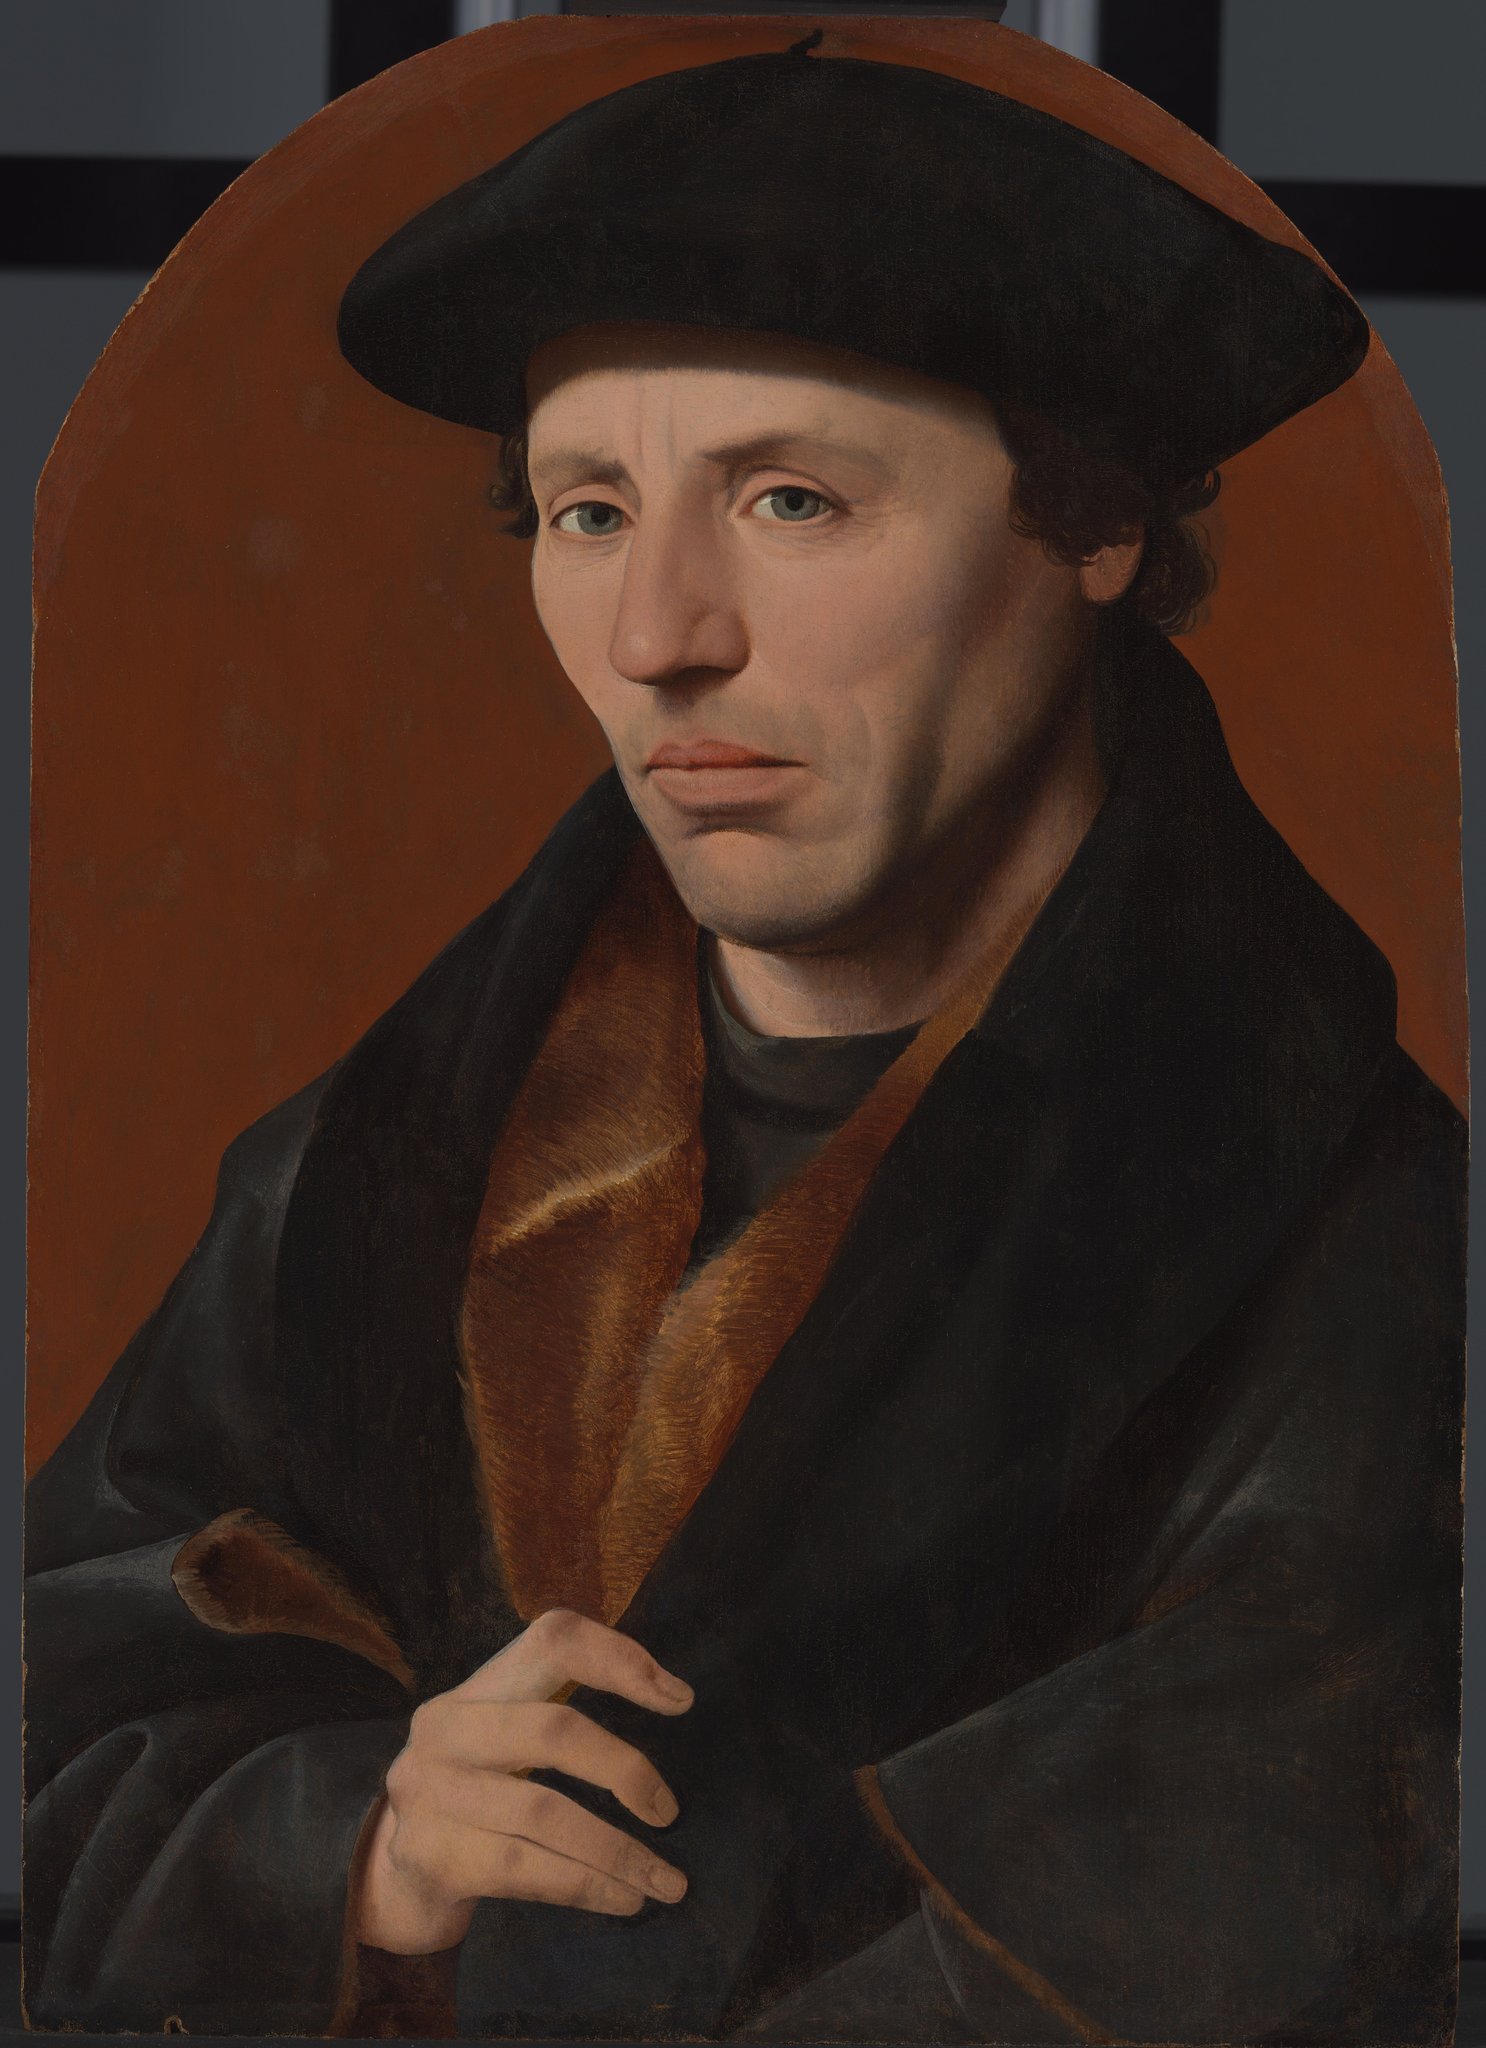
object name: painting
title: Haarlem Citizen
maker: jan van scorel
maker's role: draughtsman, painter, print maker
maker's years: 1495-1562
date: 1529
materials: oil, paint, panel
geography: haarlem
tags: head-gear: cap (+ men's clothes), anonymous historical person portrayed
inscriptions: inscription, bottom transverse of the frame, on the cartellino: ‘A[nn]o m d xxix // [A]Etate vero xlvi’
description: The only thing known about this man is inscribed in Latin on the trompe-l’oeil cartellino on the original frame: ‘In the year of our Lord 1529 / true age 46.’ The word ‘true’ implicitly emphasizes the memory of his appearance at that specific moment. The little piece of paper seems about to come loose at any moment and thus refers to the transience of earthly existence.